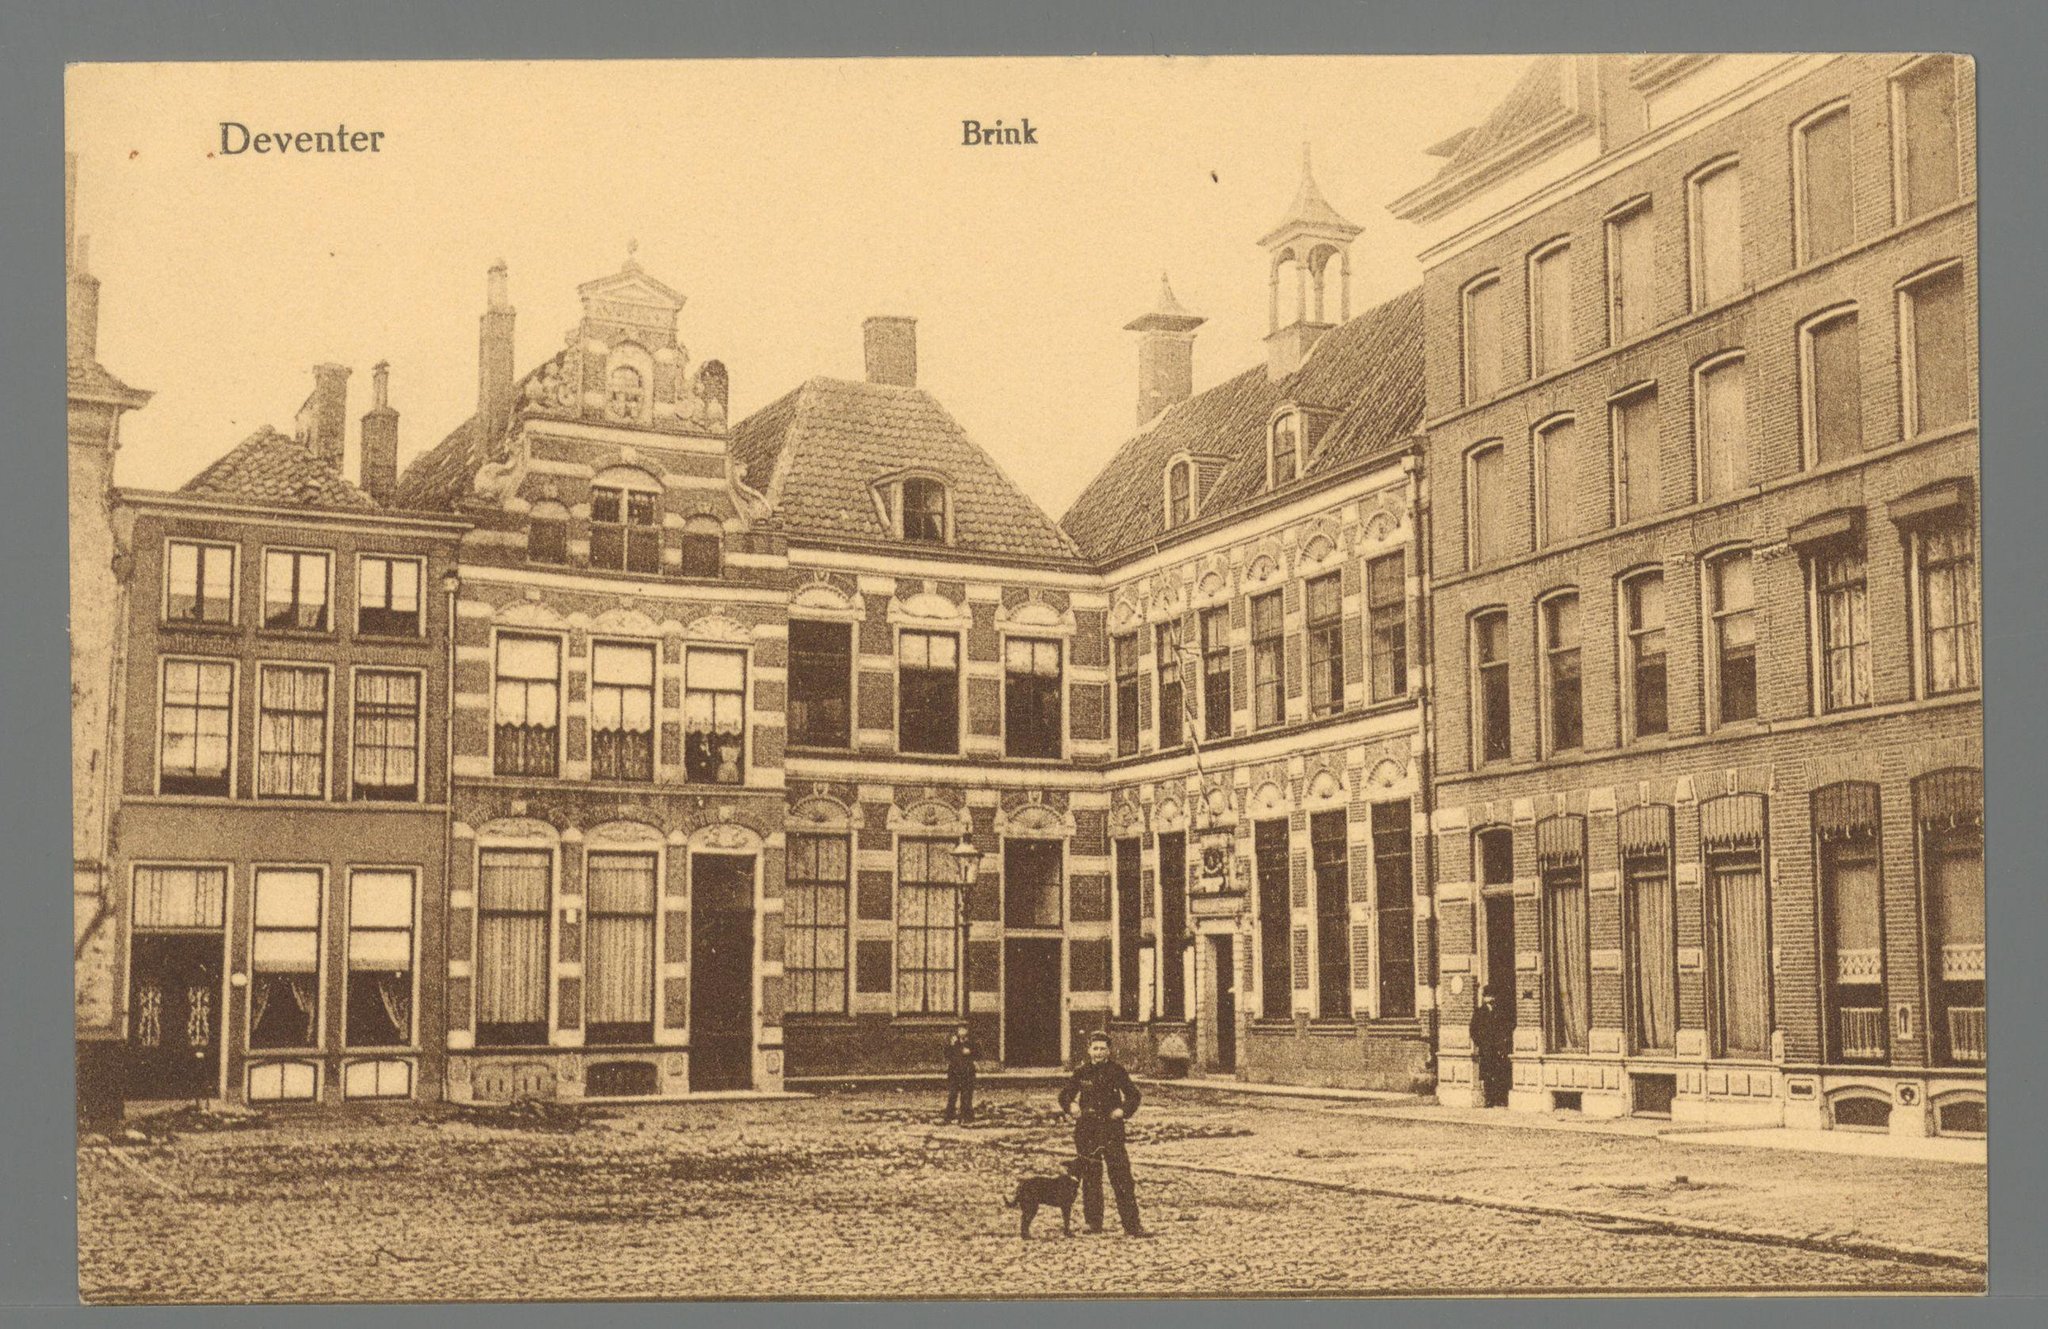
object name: ansichtkaart, prentbriefkaart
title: Deventer. Brink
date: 1905-1930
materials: cardboard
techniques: photograph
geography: amsterdam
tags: square, place, circus, etc., deventer